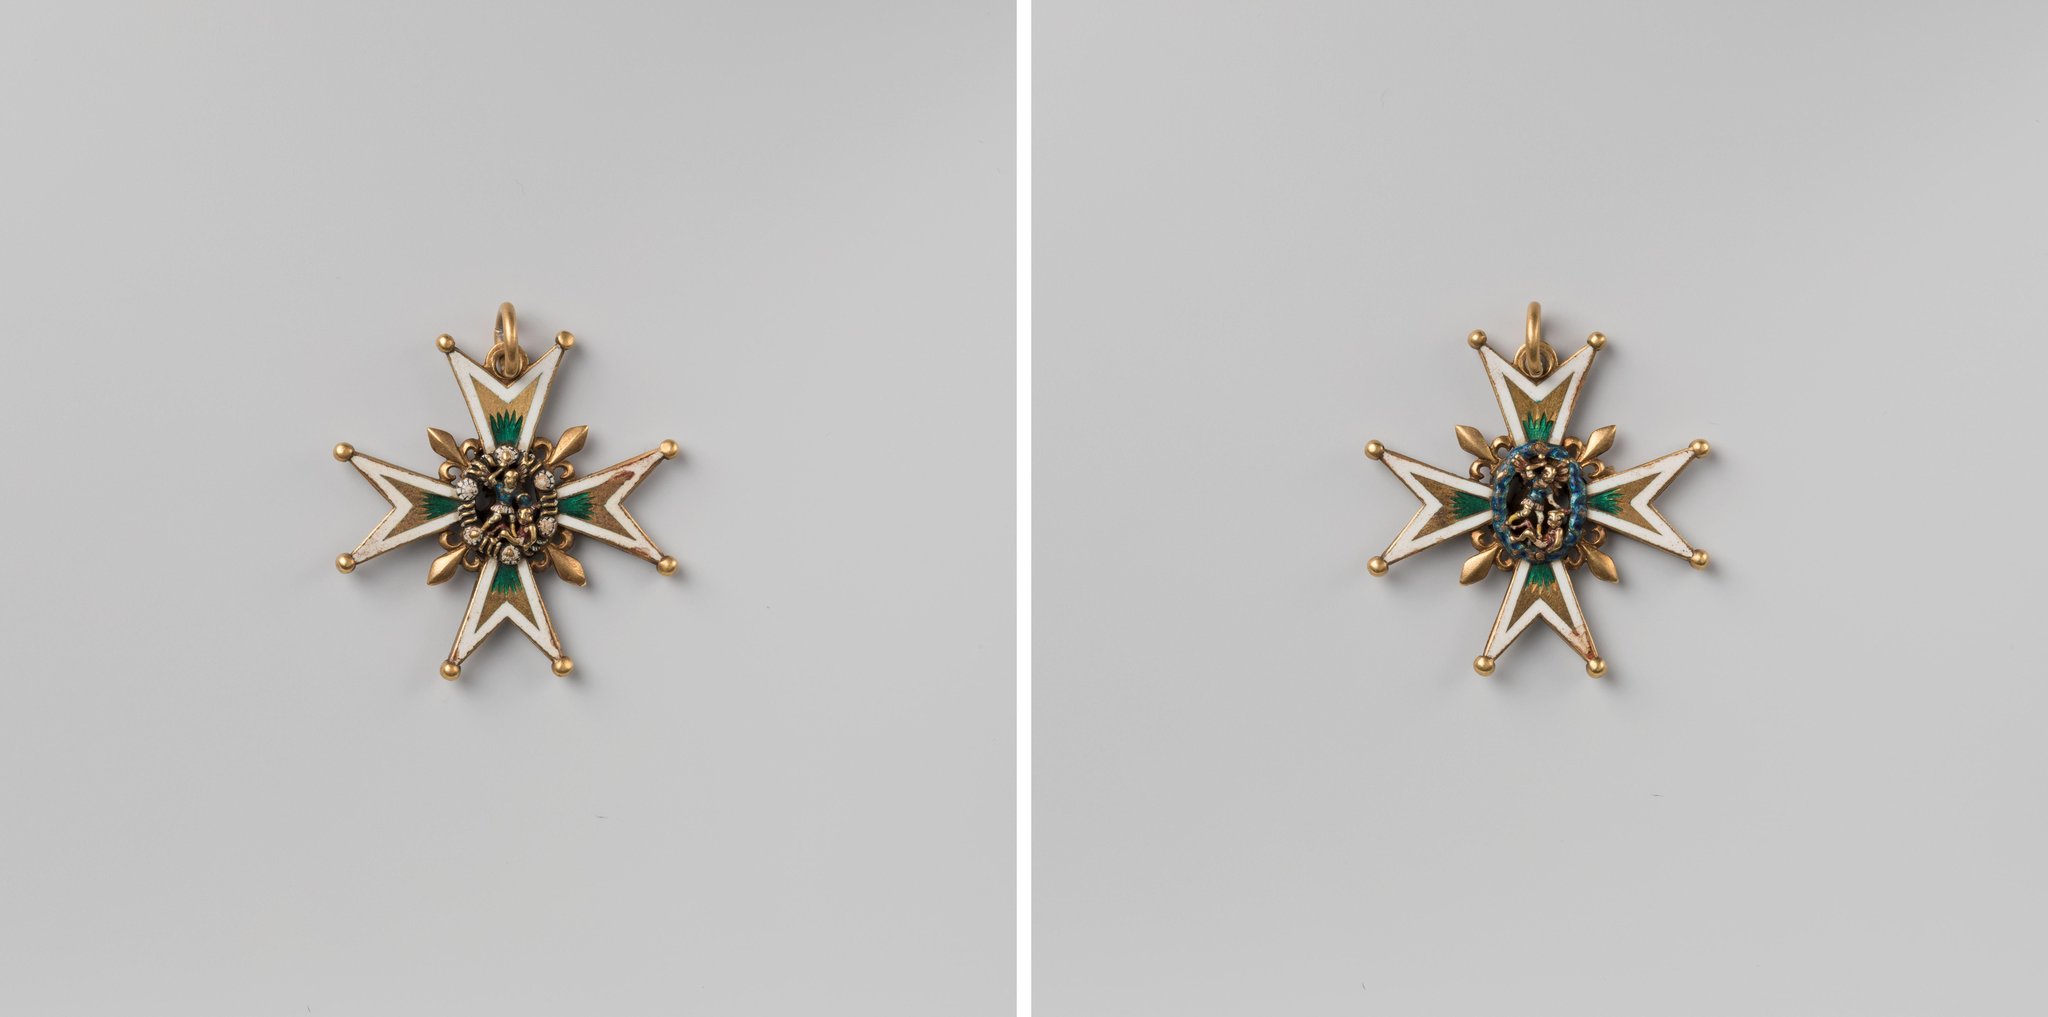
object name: insignia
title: Draagkruis van de keten van de Orde van St. Michel van Cornelis Lampsins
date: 1662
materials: gold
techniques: forging, striking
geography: france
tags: lodewijk xiv (koning van frankrijk)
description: Malthezer kruis met 'parels' (bolletjes) op de punten, tussen de armen telkens de Franse lelie. In het midden in een ovale krans voorstelling van een engel (St. Michel) met opgeheven armen en één voet op liggende demon. Aan de ene zijde is de ovalen krans versierd met witte Jacobsschelpen en draagt de engel aan de linkerarm een schild; aan de andere zijde blauwe ovalen krans en engel zonder schild. Het zwaard is in beide gevallen onduidelijk (afwezig?). Kruis versierd met wit-email randen en groene vlam.